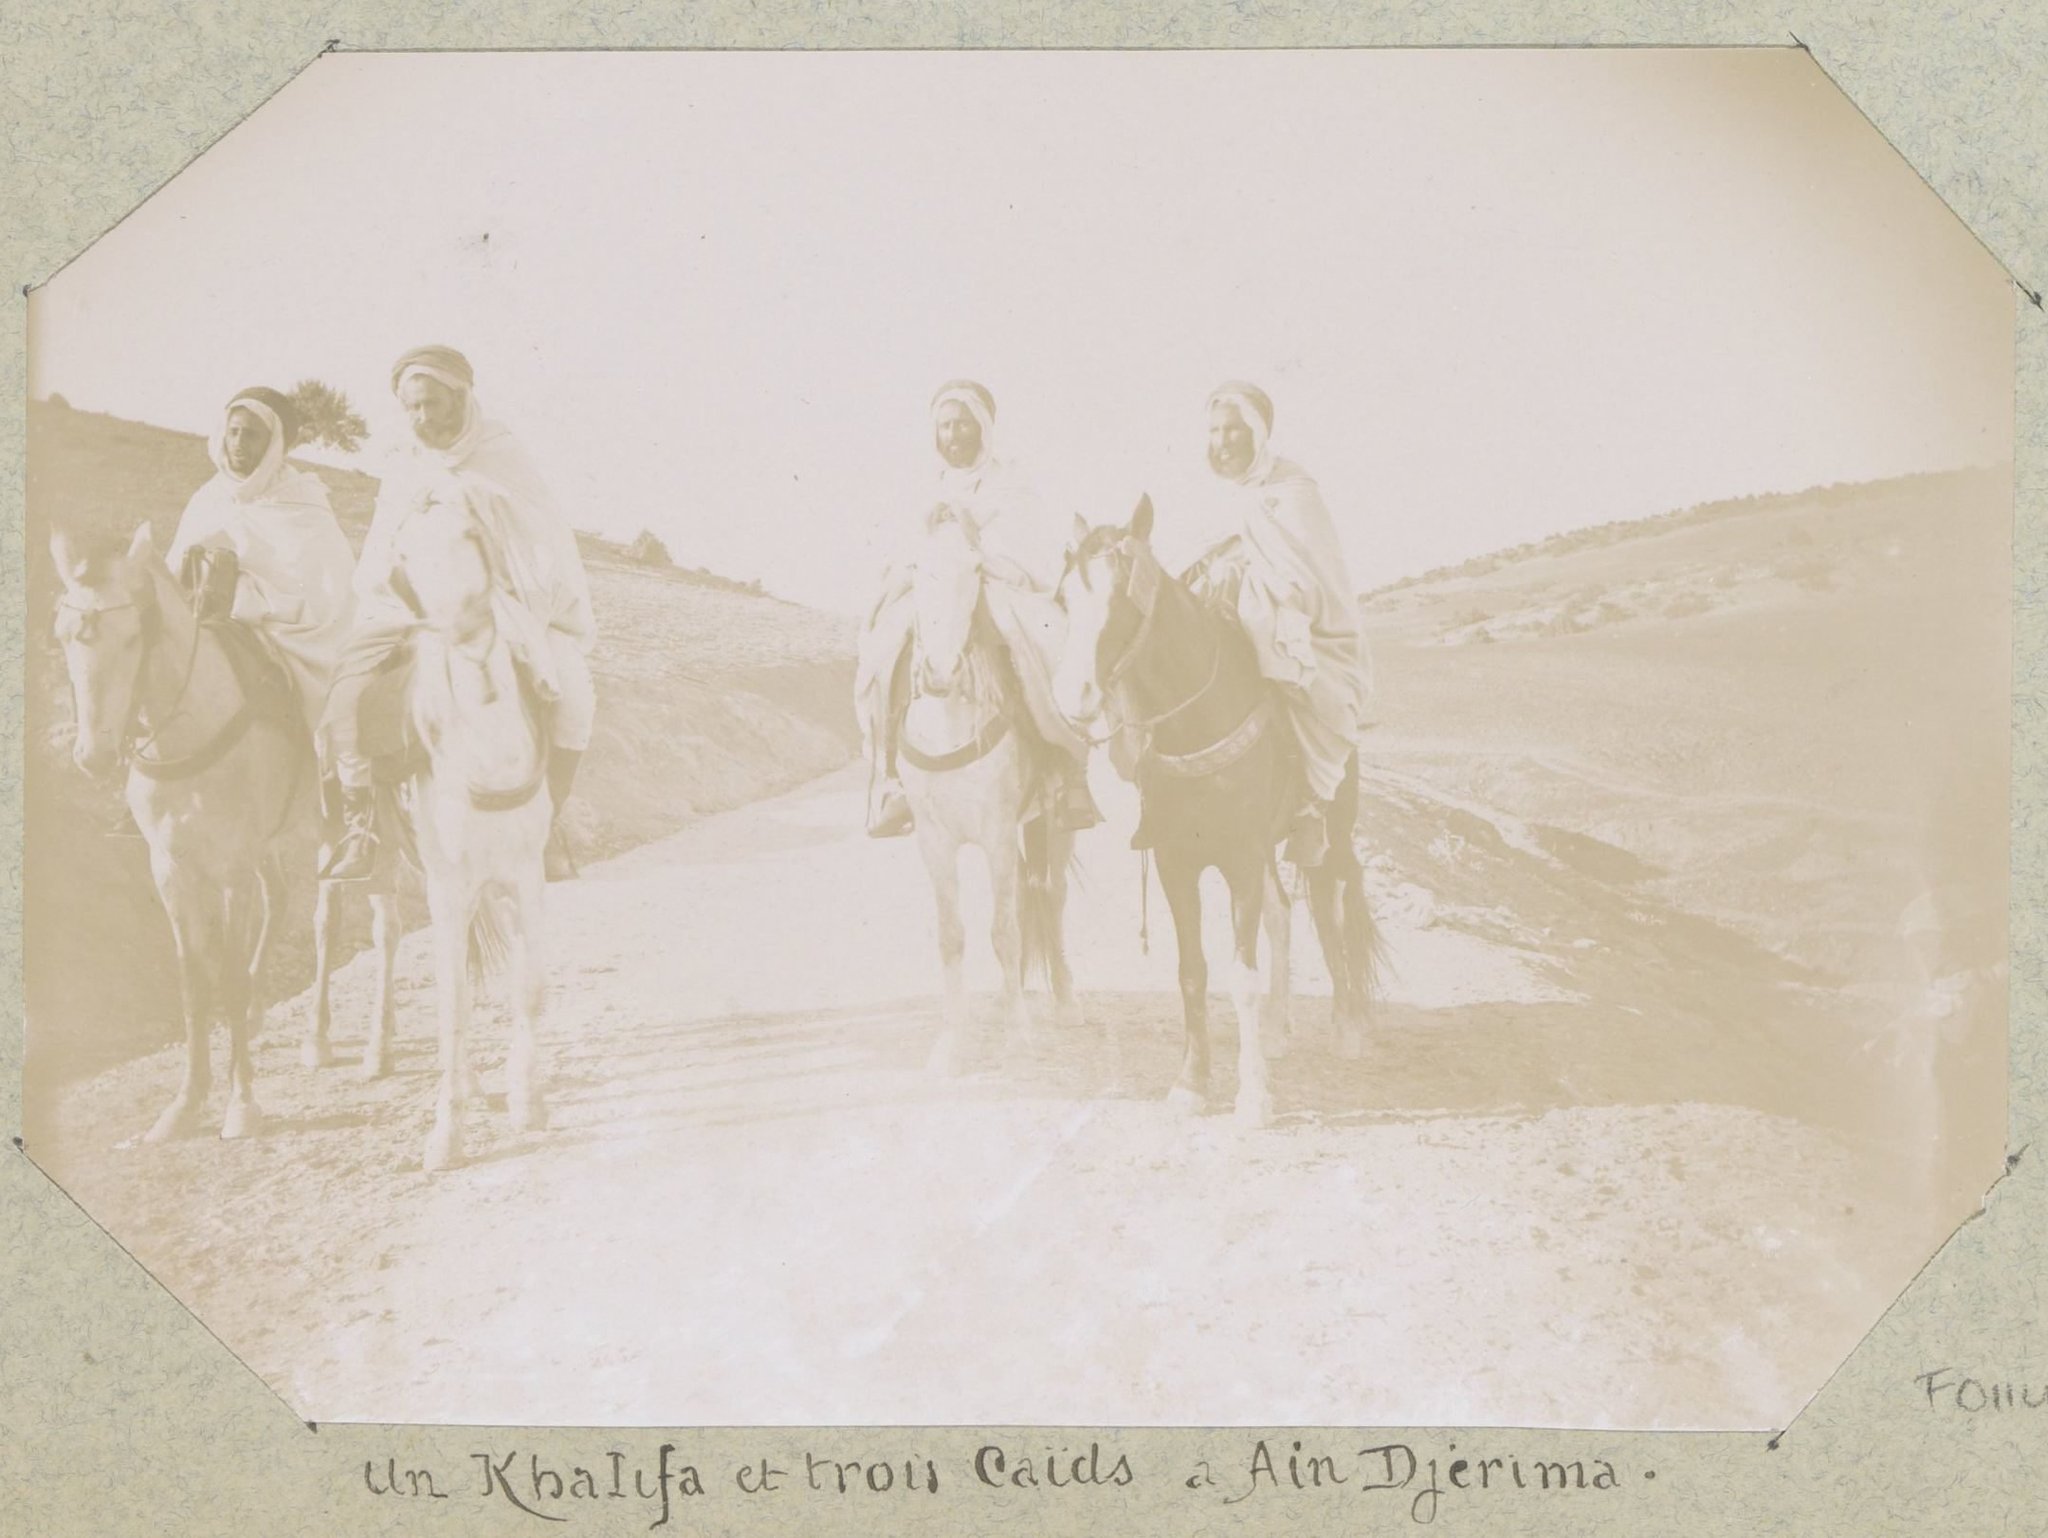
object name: photograph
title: Kalief en drie caïds te paard in Ain Djerima (Algerije)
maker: Anonymous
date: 1802-1896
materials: paper, photographic support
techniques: daylight paper print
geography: algeria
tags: riding a horse, ass, or mule; rider, horseman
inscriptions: inscription: ‘1 Khalifa et 3 Caïds Ouad Seghouane Beni Hassen B.a Mte. Mégane Chellalla Fevriers 96 Ain Djerima (fontaine de la gorgée)’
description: Onderdeel van Album van een Franse amateur met foto's van Frankrijk, Algerije, Palmyra, de Wereldtentoonstelling van 1900 en van bekende Fransen.